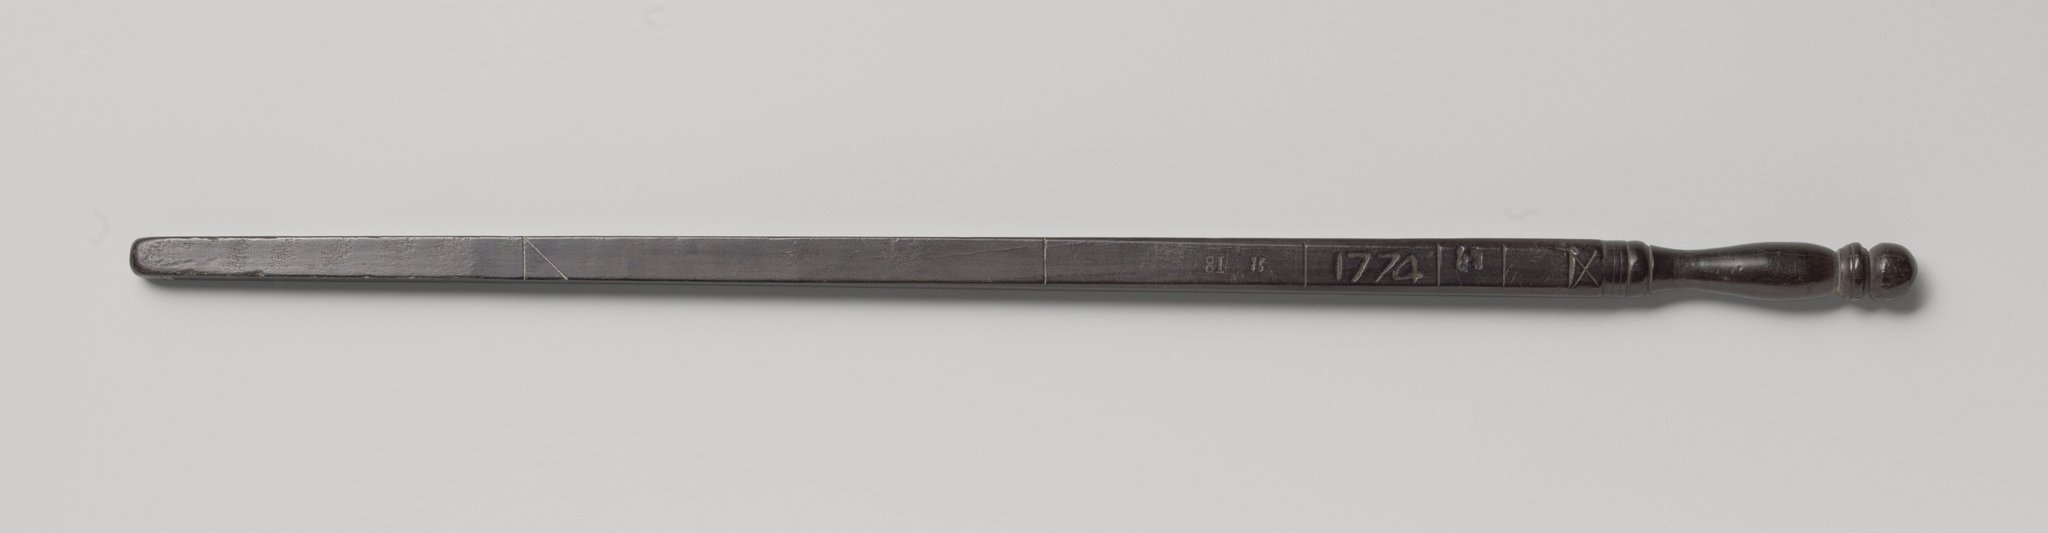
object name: measuring rod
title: Maatstok van palissanderhout met jaartal 1774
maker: Anonymous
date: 1774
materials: wood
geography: northern netherlands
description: Maatstok van palissanderhout. De stok is in doorsnede vierkant en verjongt zich naar onderen. De knop is balustervormig. Op de stok is het jaartal 1774 aangebracht en een ijkteken (81JC) en maatstrepen.